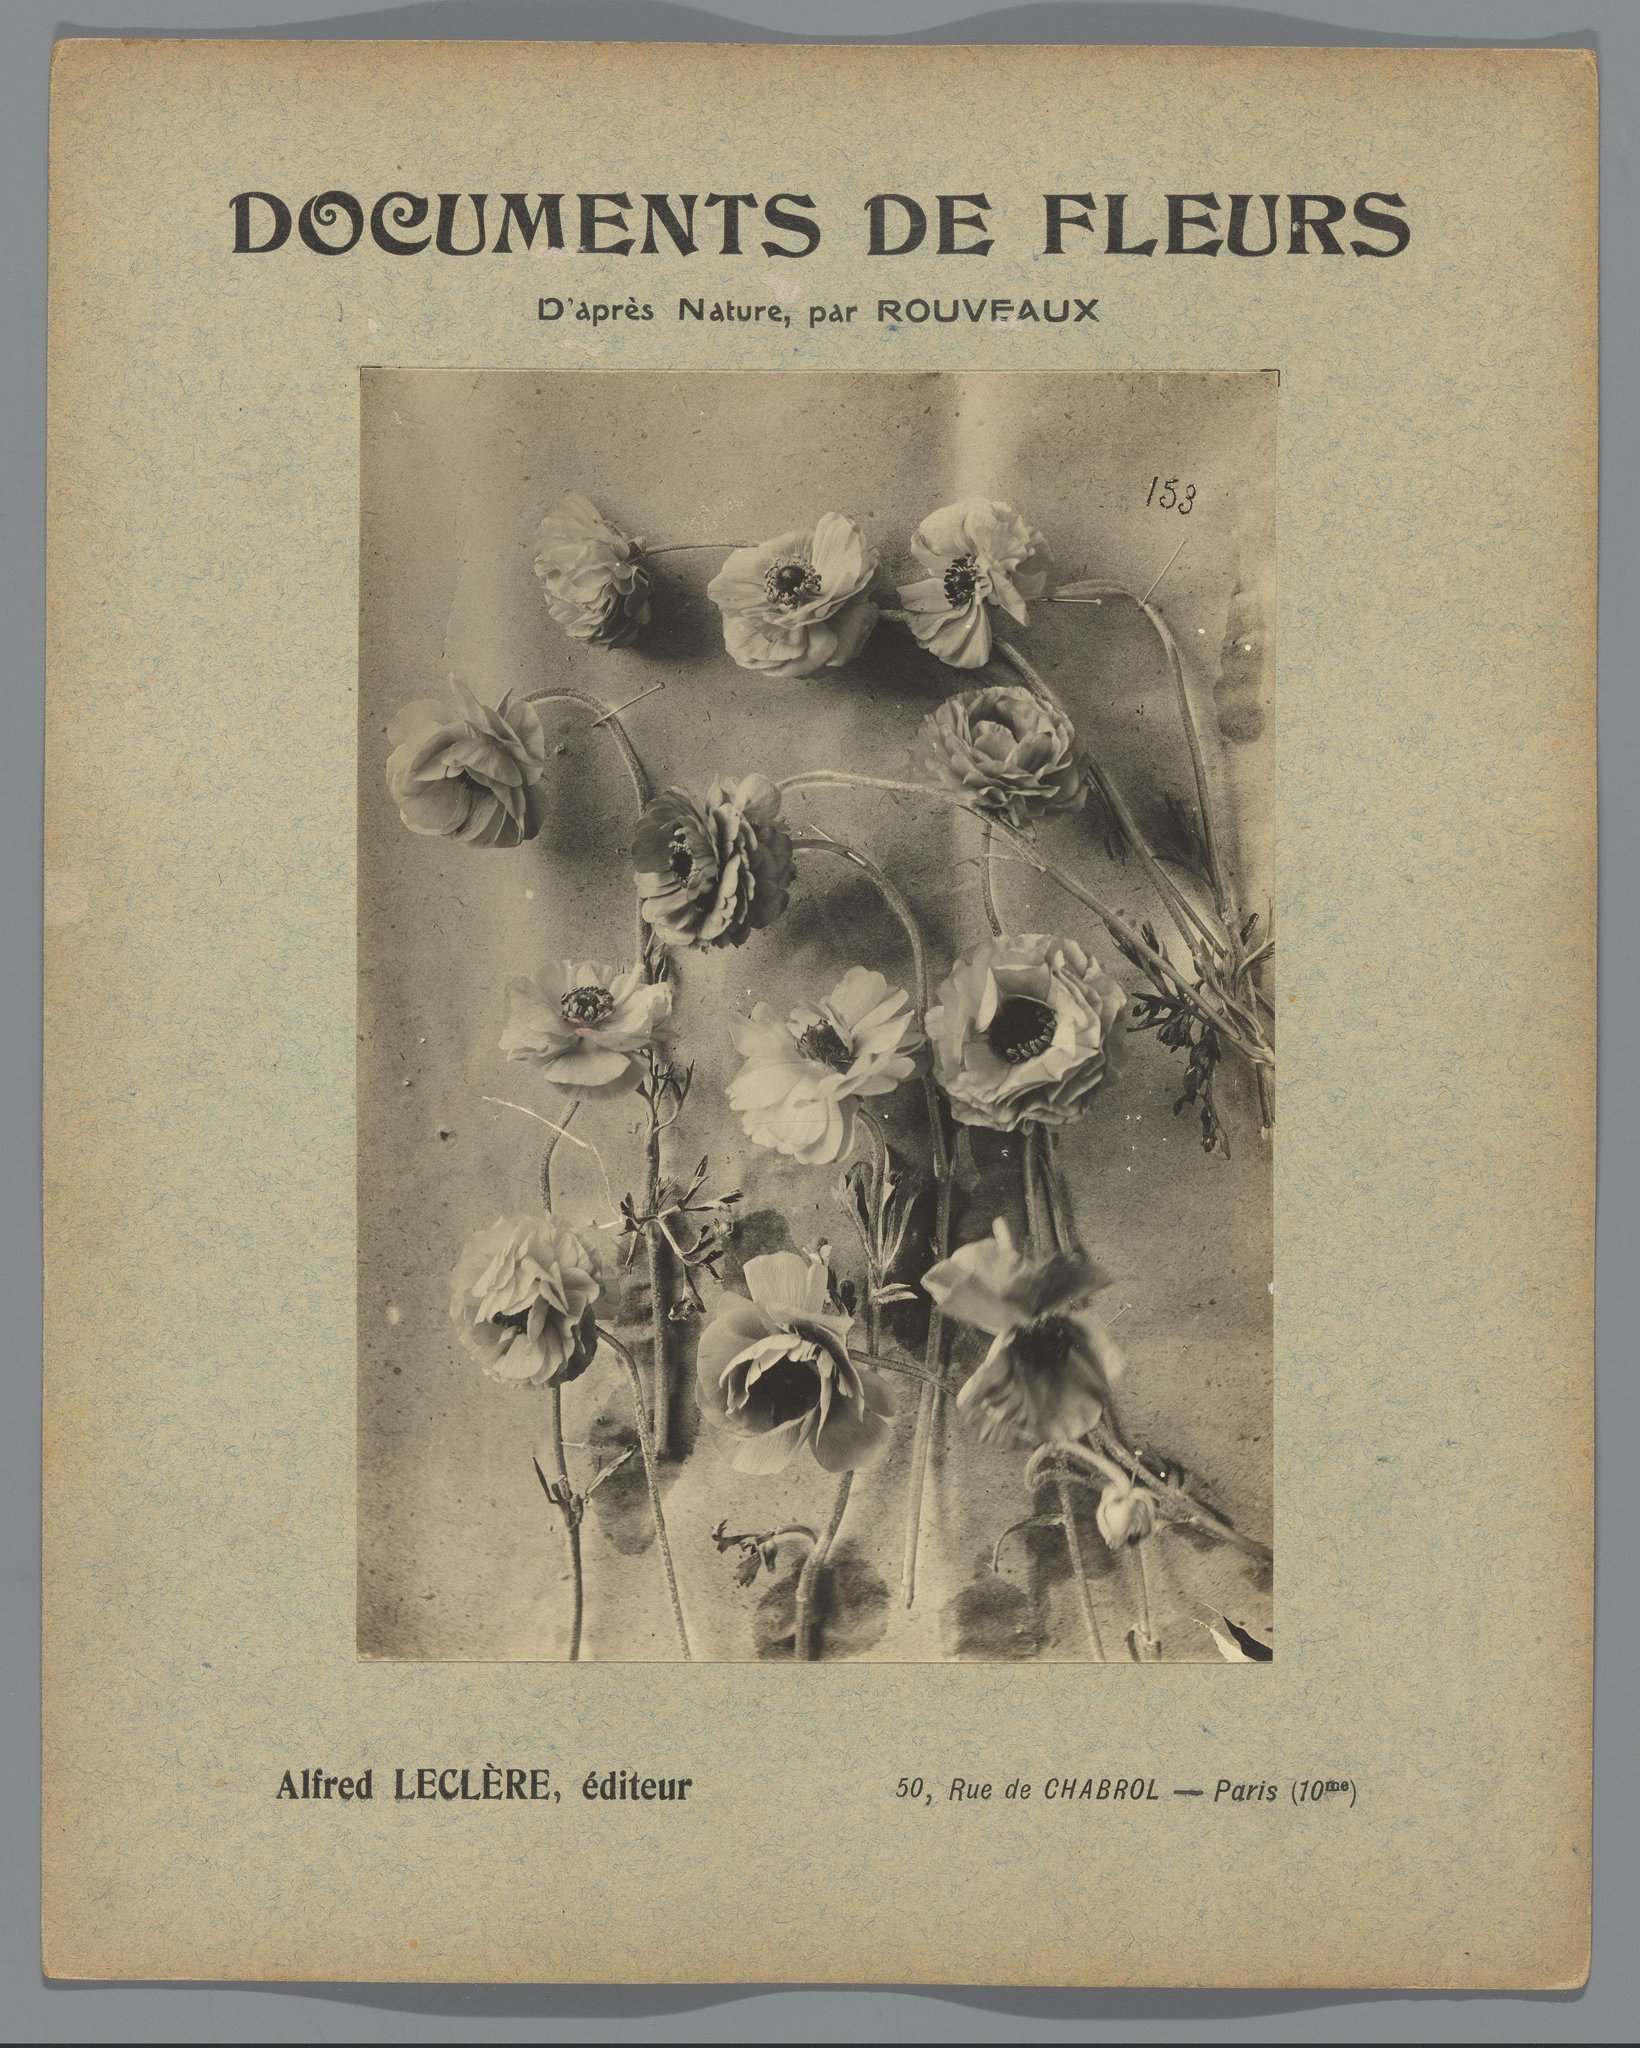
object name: photograph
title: Bloemstudie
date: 1895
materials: photographic support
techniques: gelatin silver print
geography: france